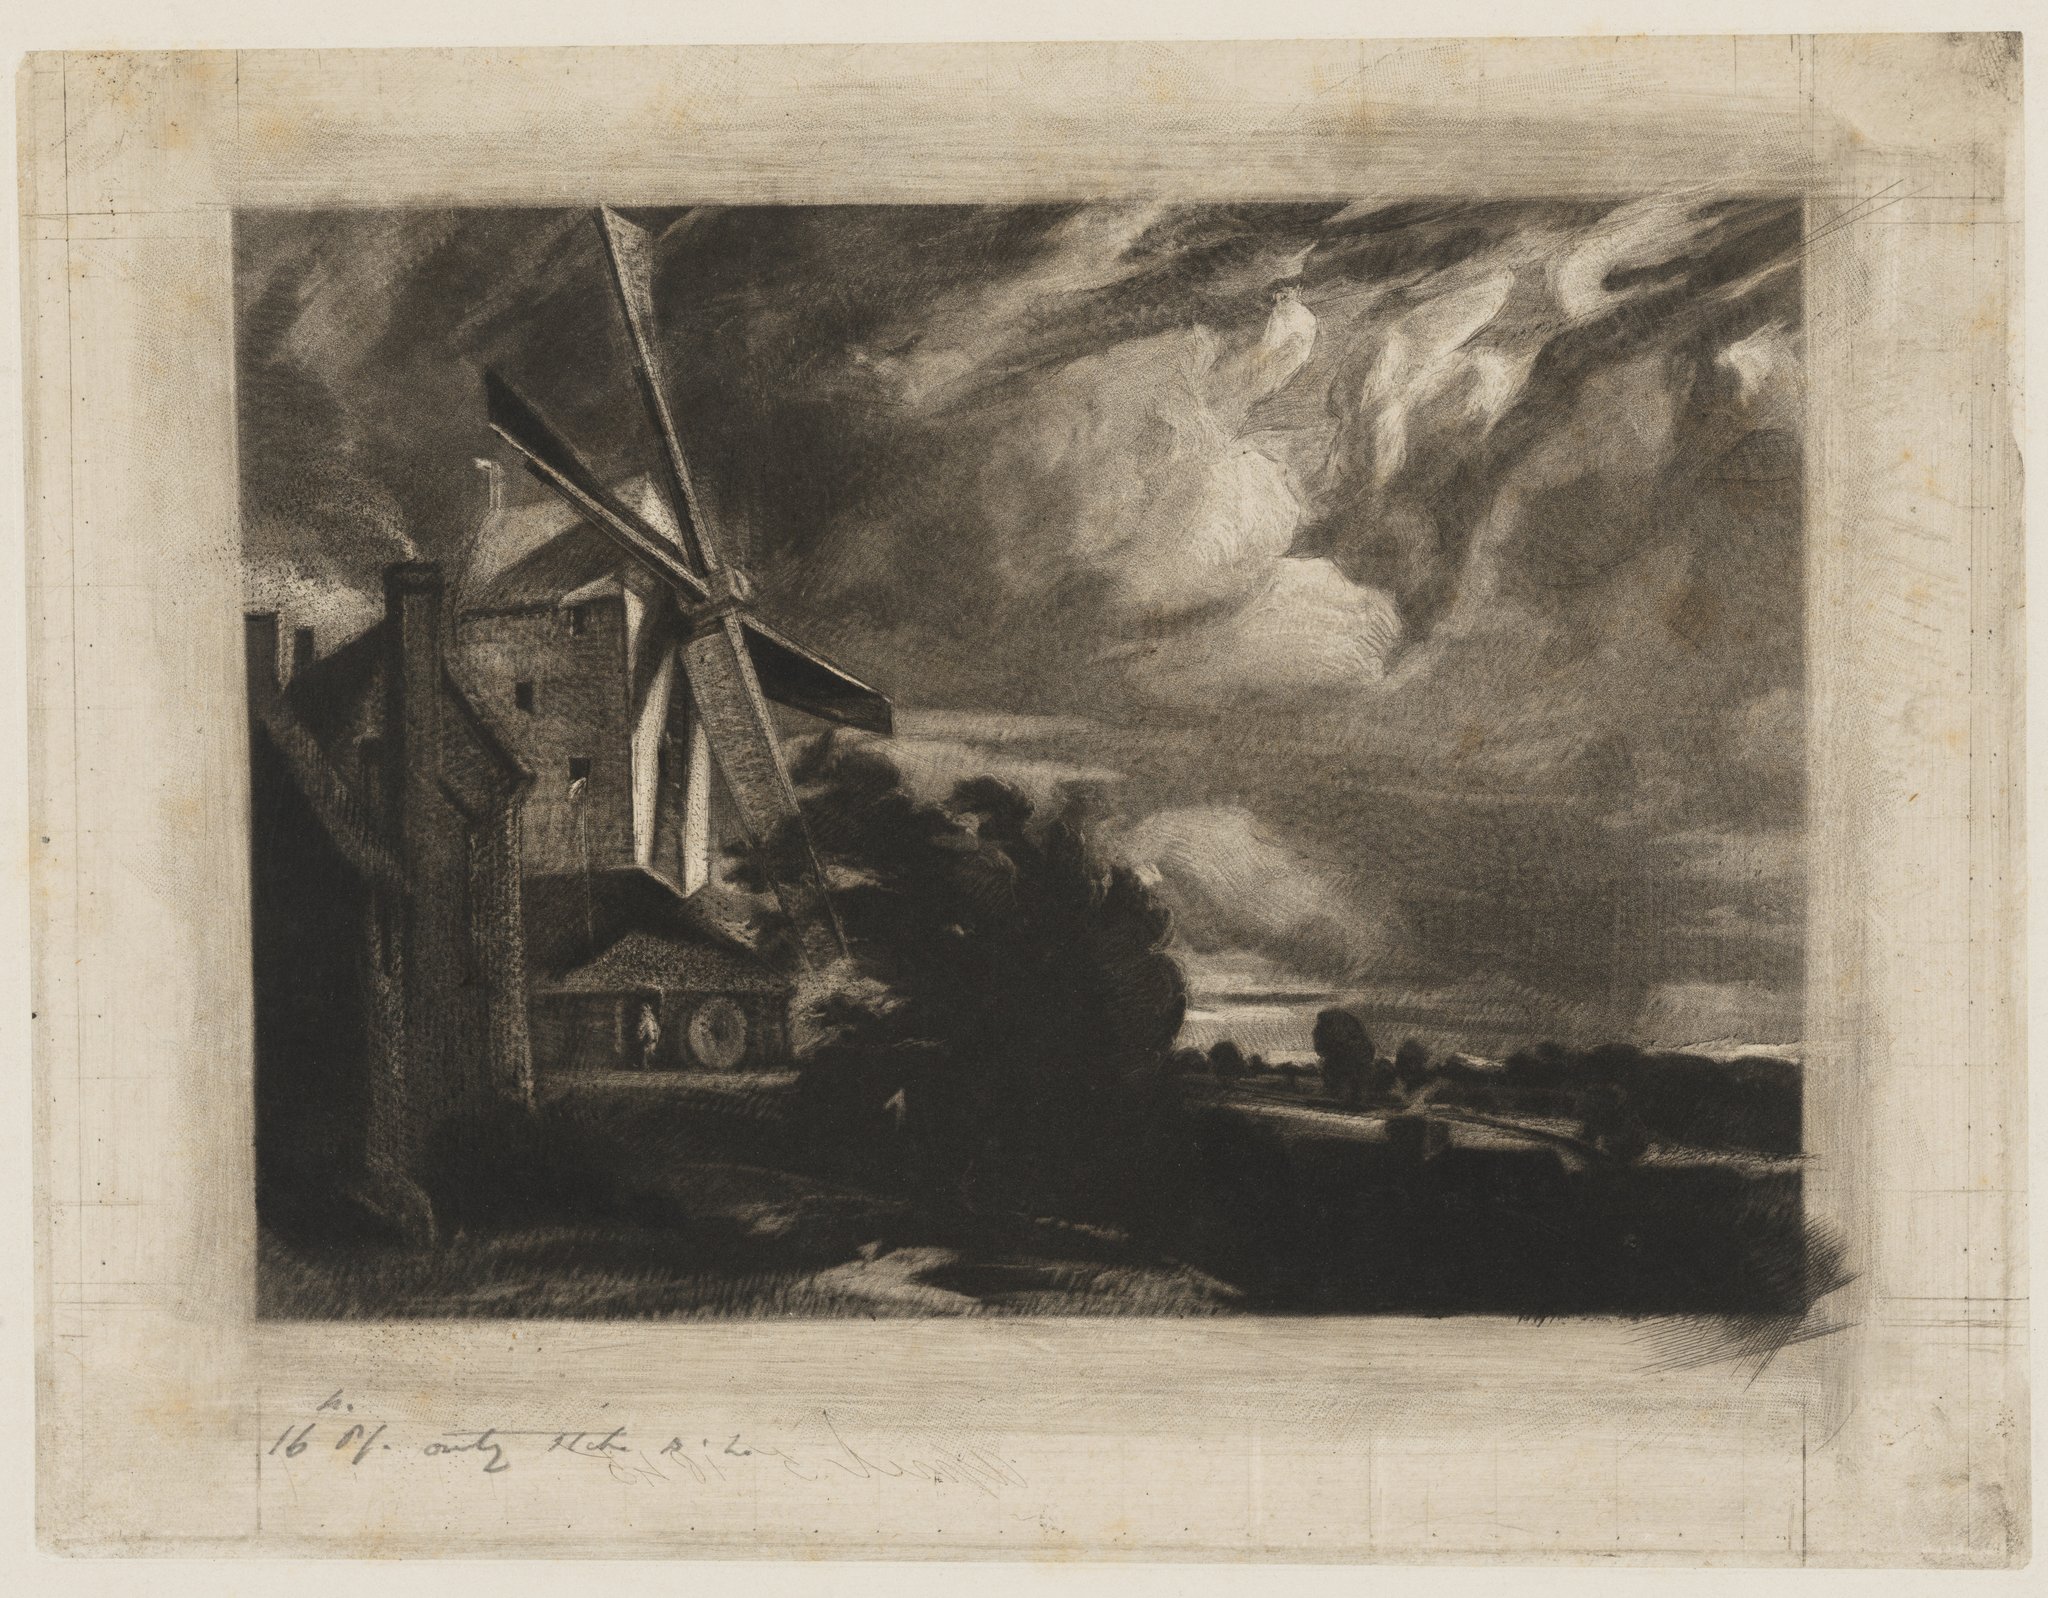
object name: print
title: Mill near Colchester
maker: david lucas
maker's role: engraver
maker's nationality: british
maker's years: 1802-1881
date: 1845-1846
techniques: mezzotint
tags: windmills